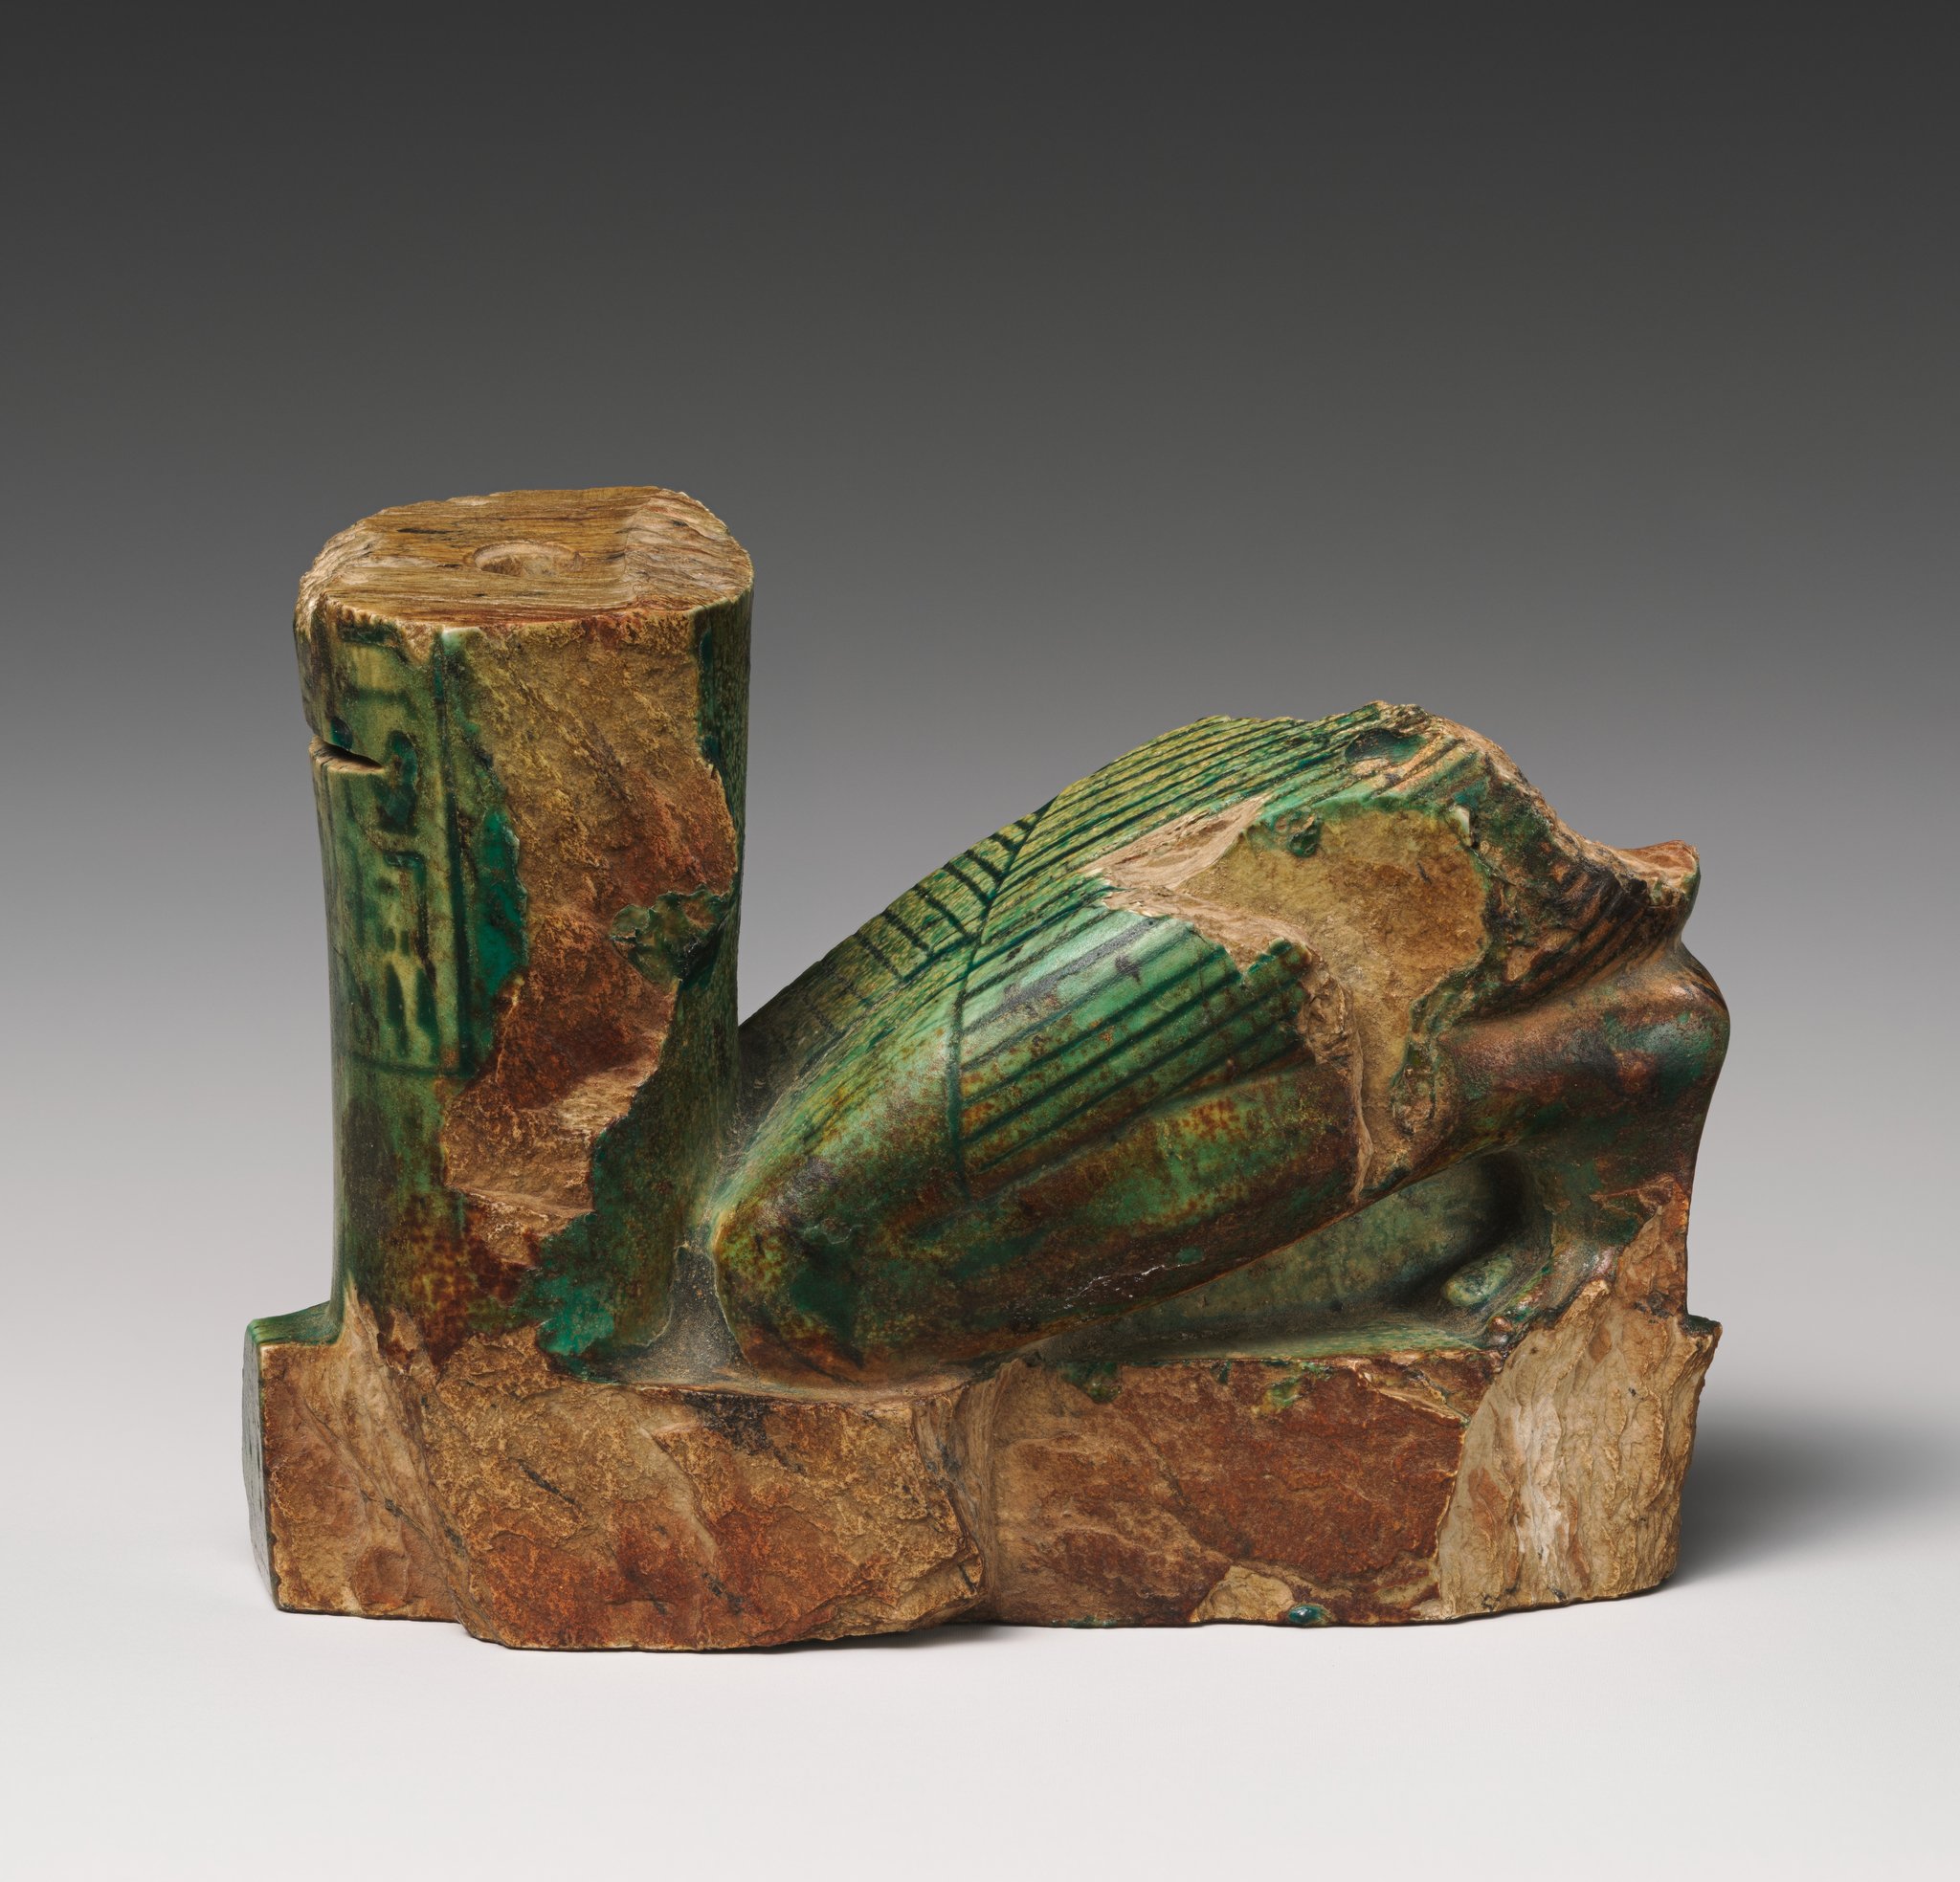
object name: statuette, king shabaqo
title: Fragmenary statuette of kneeling King Shabaqo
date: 712-698 BCE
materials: paint, stone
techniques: glazing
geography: egypt and sudan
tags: kings